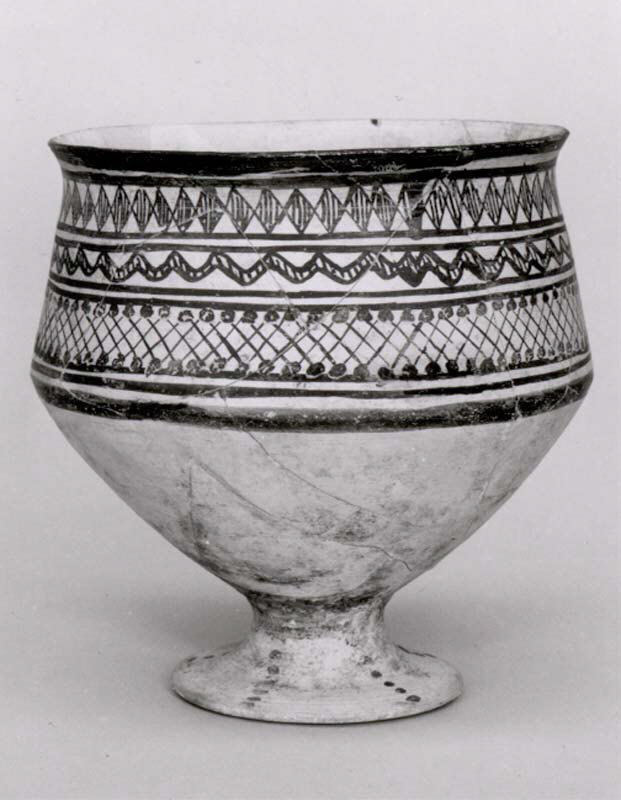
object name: goblet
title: Goblet with geometric designs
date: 4000-3668 BCE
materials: ceramic, paint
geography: central iran